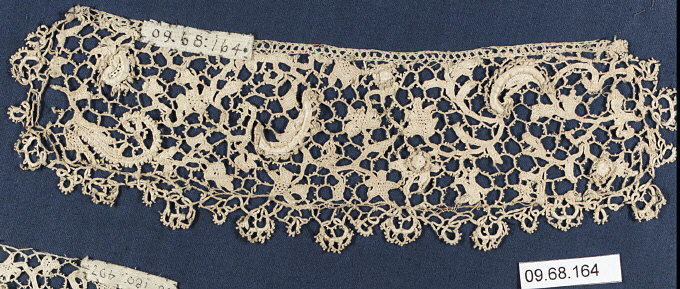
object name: cuff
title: Cuff (one of a pair)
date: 1667-1700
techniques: lace